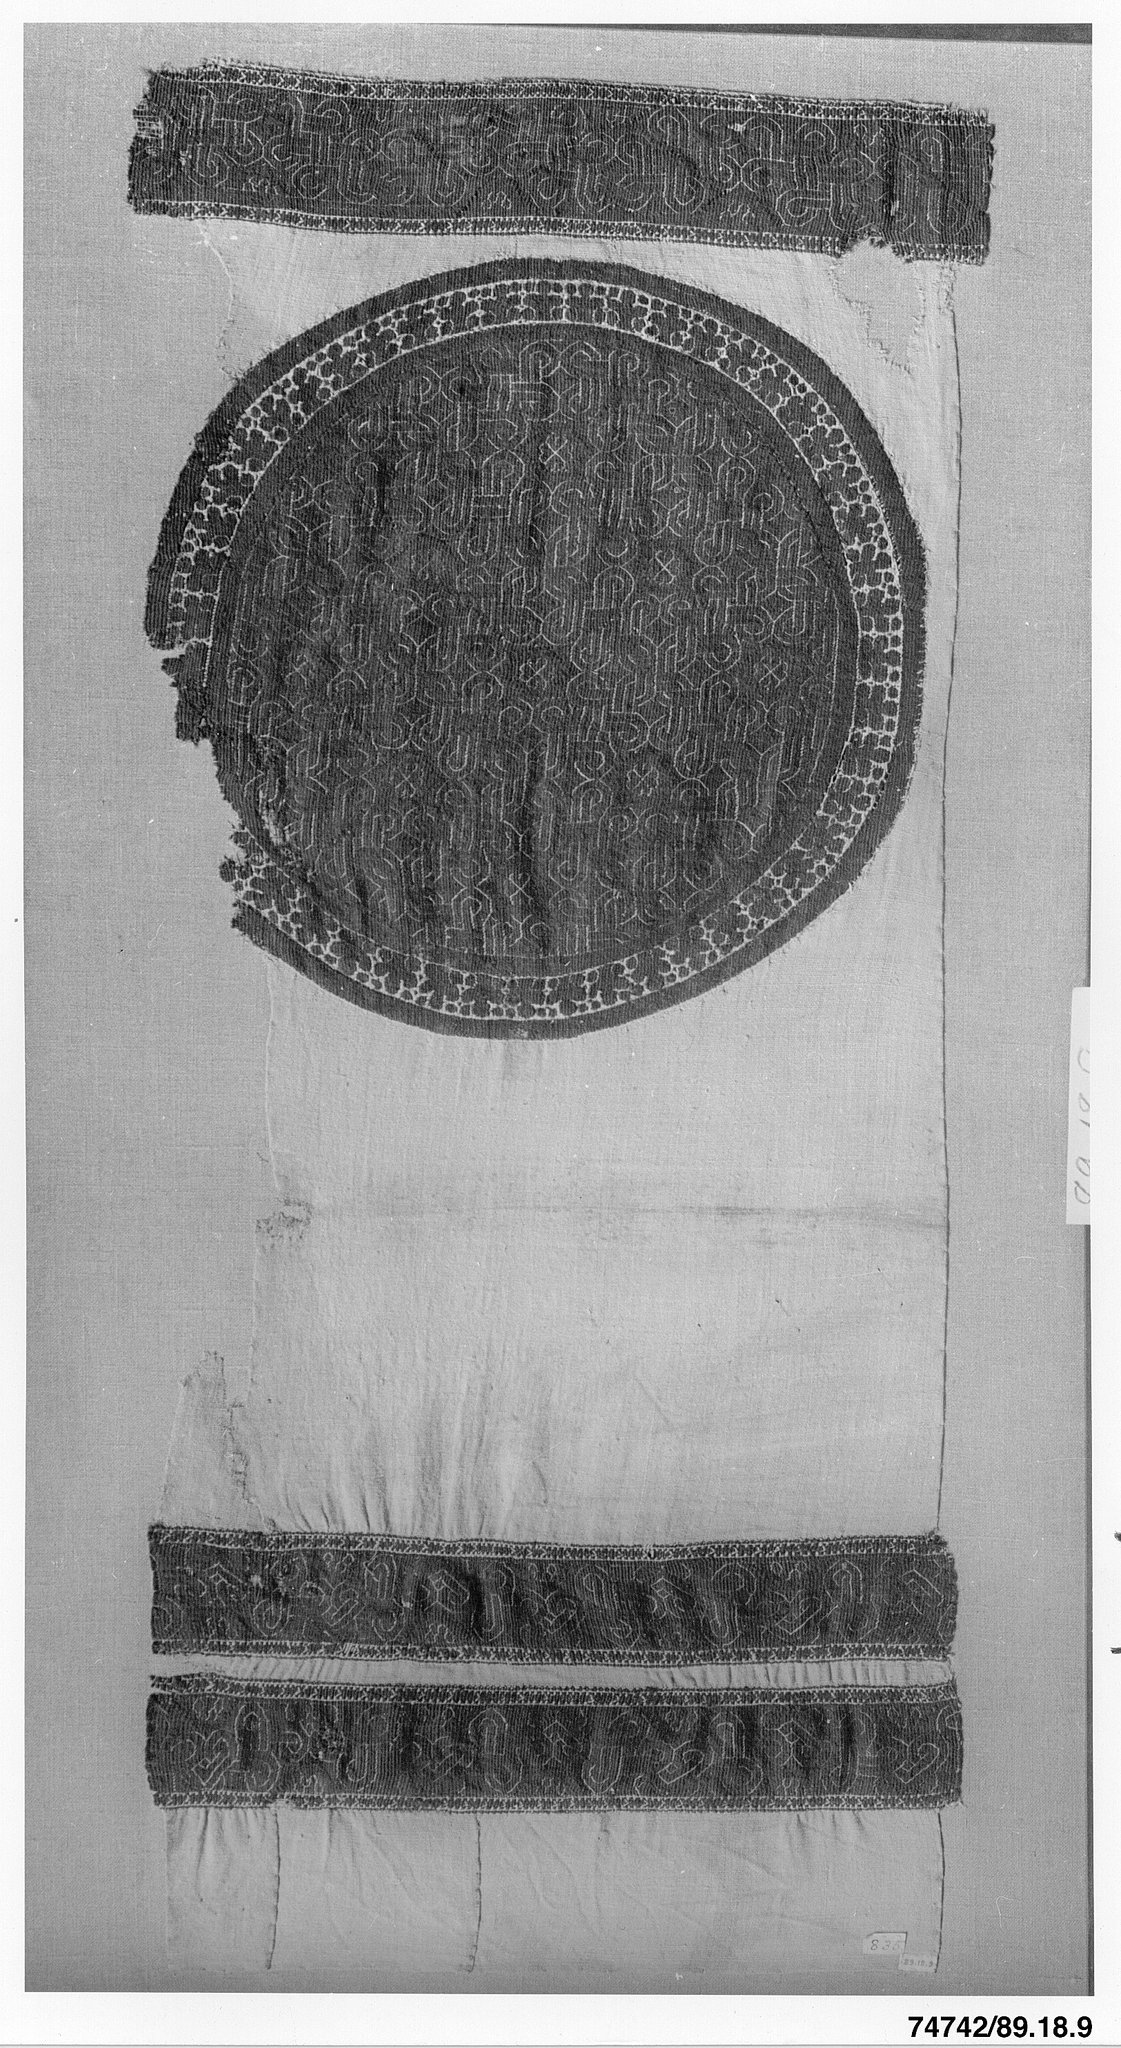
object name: textile fragment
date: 201-400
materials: linen, wool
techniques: weave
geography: egypt